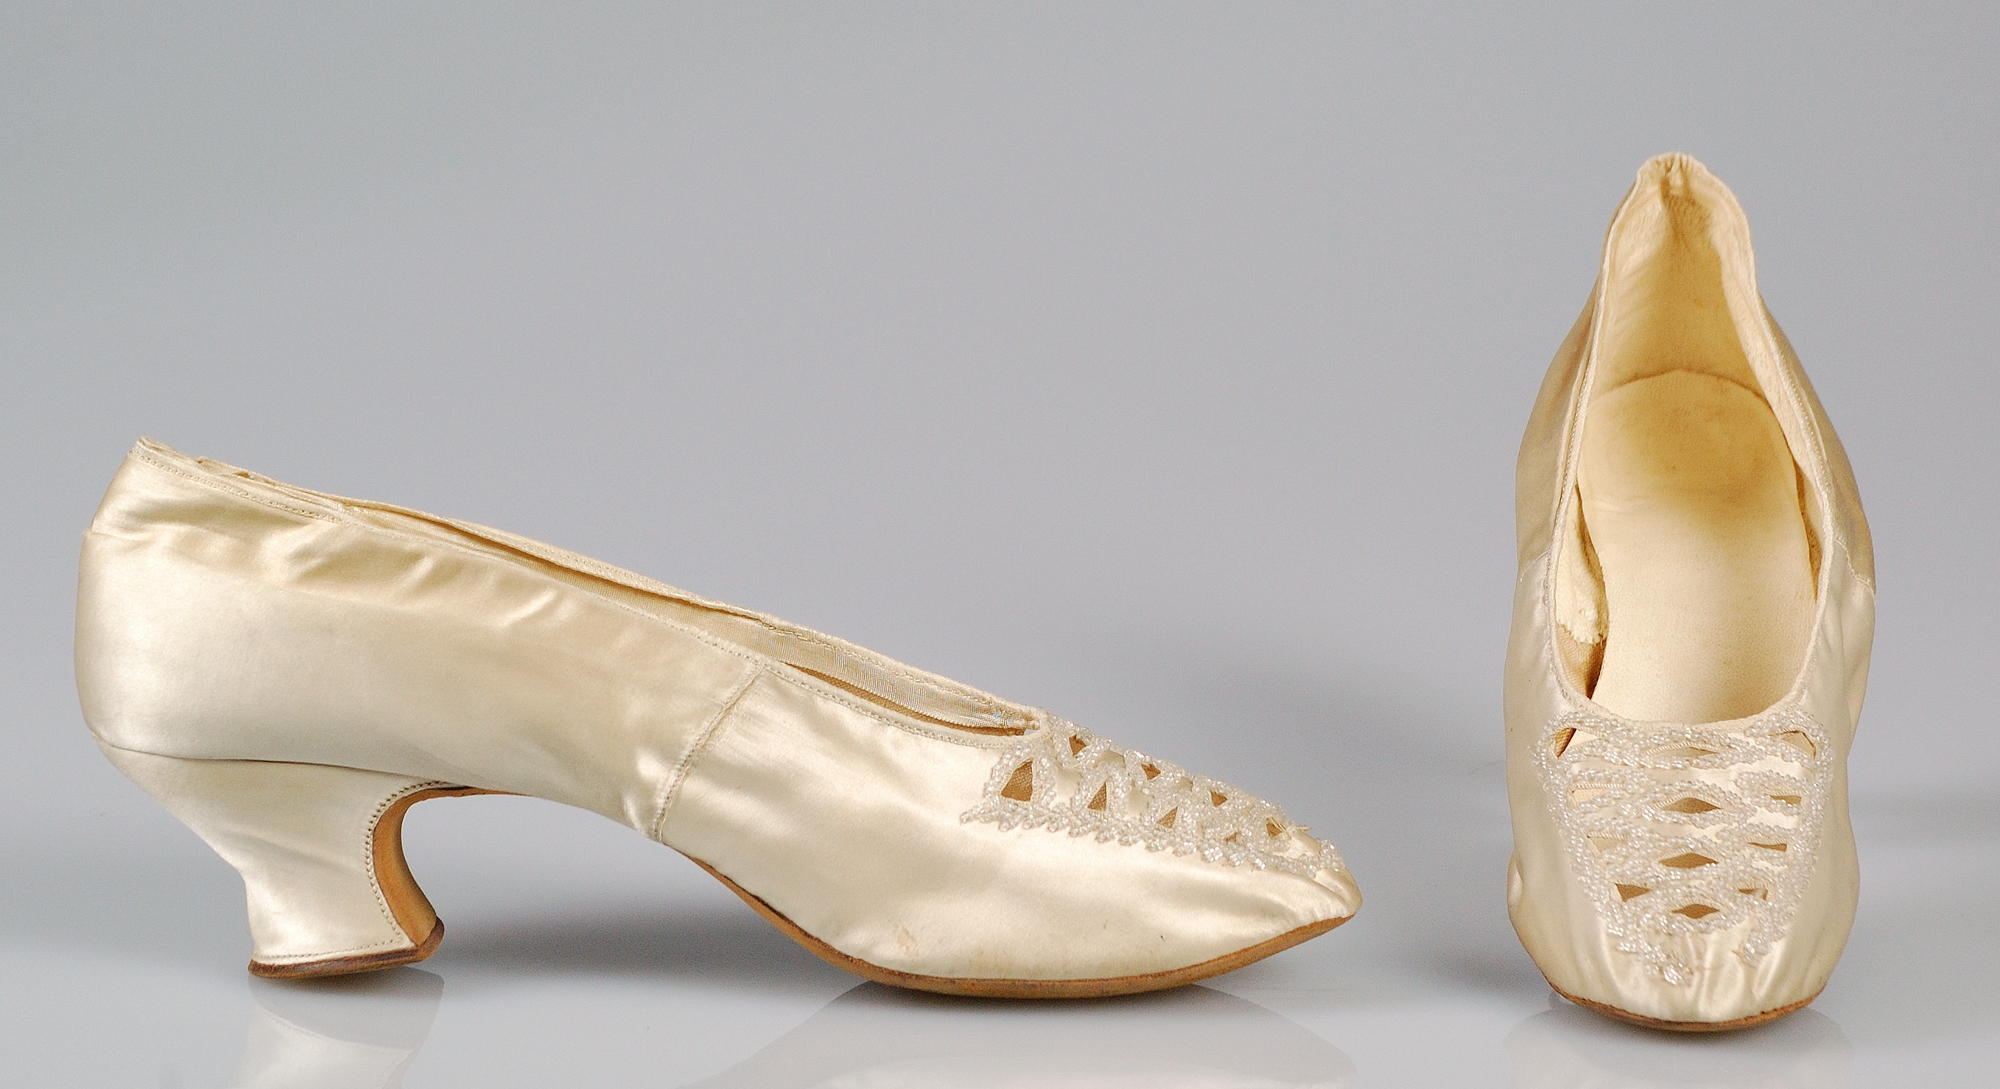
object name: wedding slipper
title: Wedding slippers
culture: american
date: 1875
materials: silk